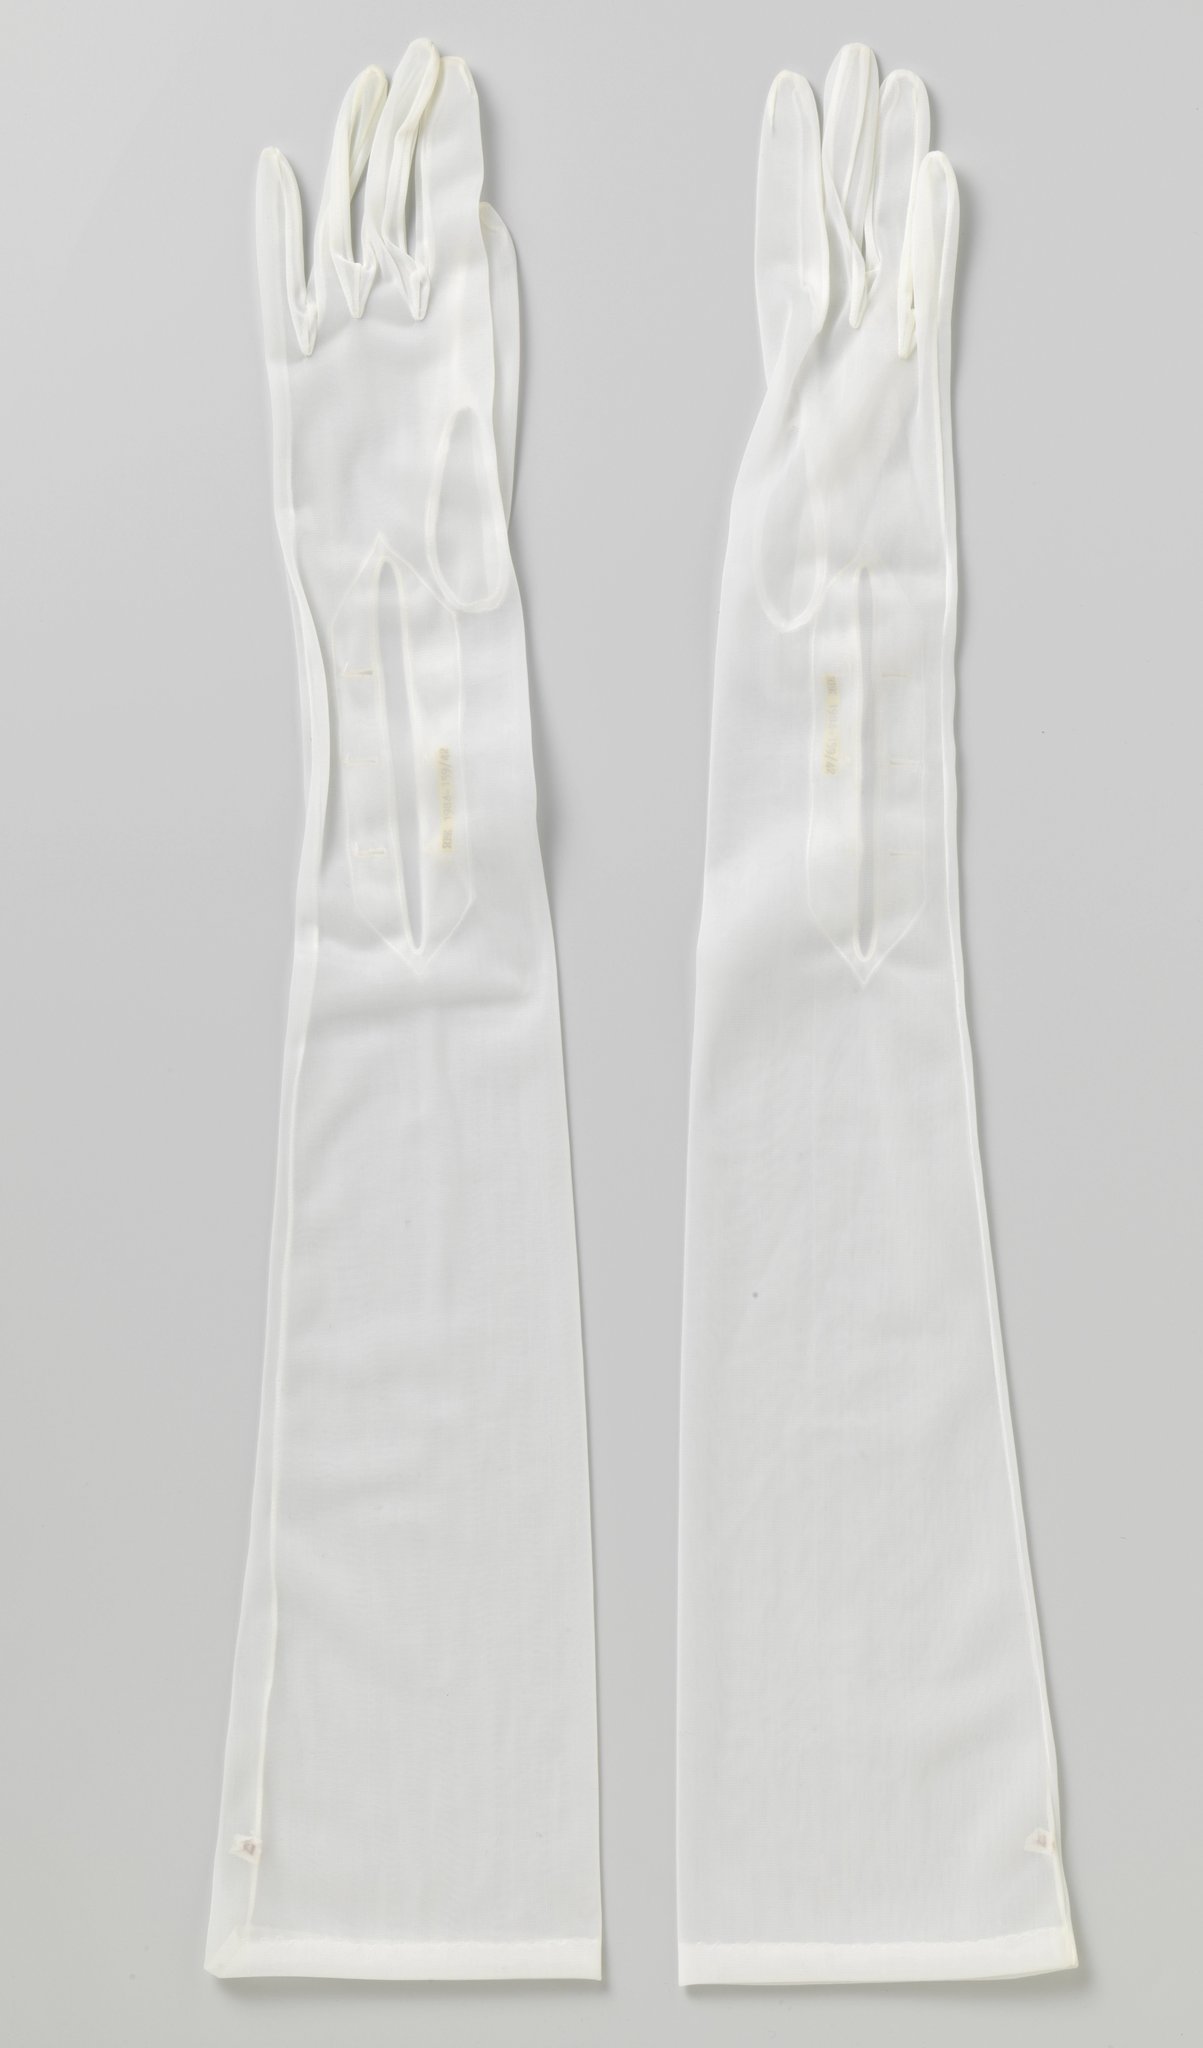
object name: evening glove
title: Handschoen van witte stretch nylon met knopen van kunststof, parelmoerkleurig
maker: Anonymous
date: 1950-1960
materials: cotton, plastic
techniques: casting, weave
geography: netherlands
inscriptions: number: ‘7’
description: Linkerhandschoen van onversierde witte stretch nylon. Opening aan binnenkant pols, voorzien met knopen van kunststof, parelmoerkleurig waarvan een ontbreekt.